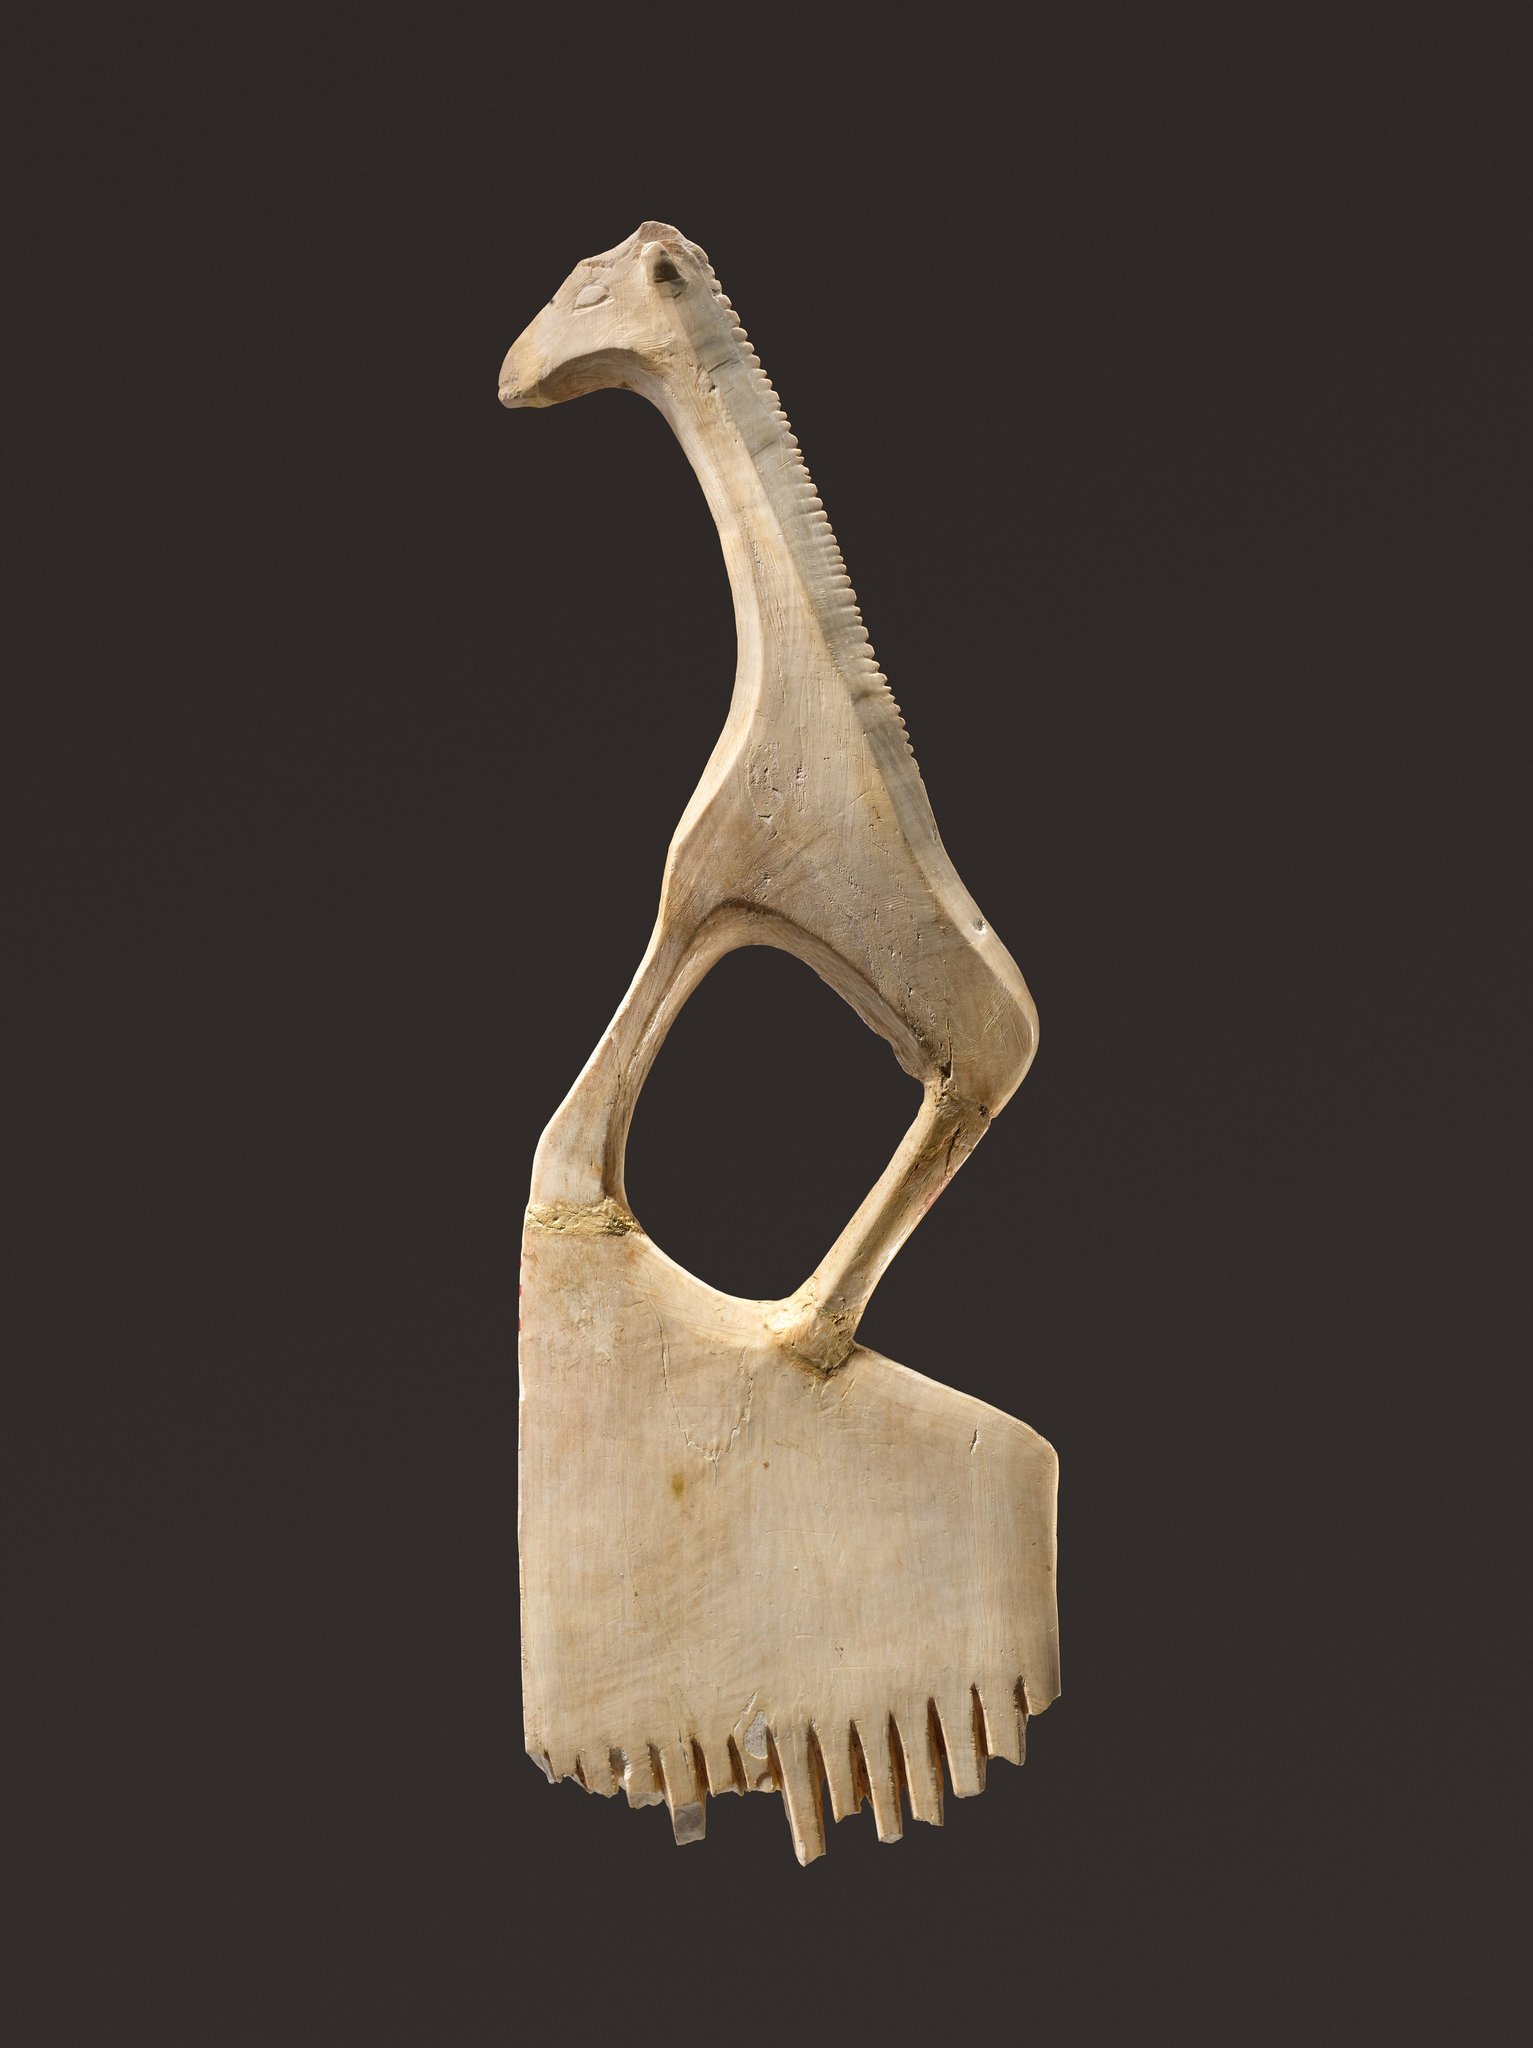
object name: comb, giraffe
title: Comb with a giraffe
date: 3900-3500 BCE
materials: ivory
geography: egypt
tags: giraffes